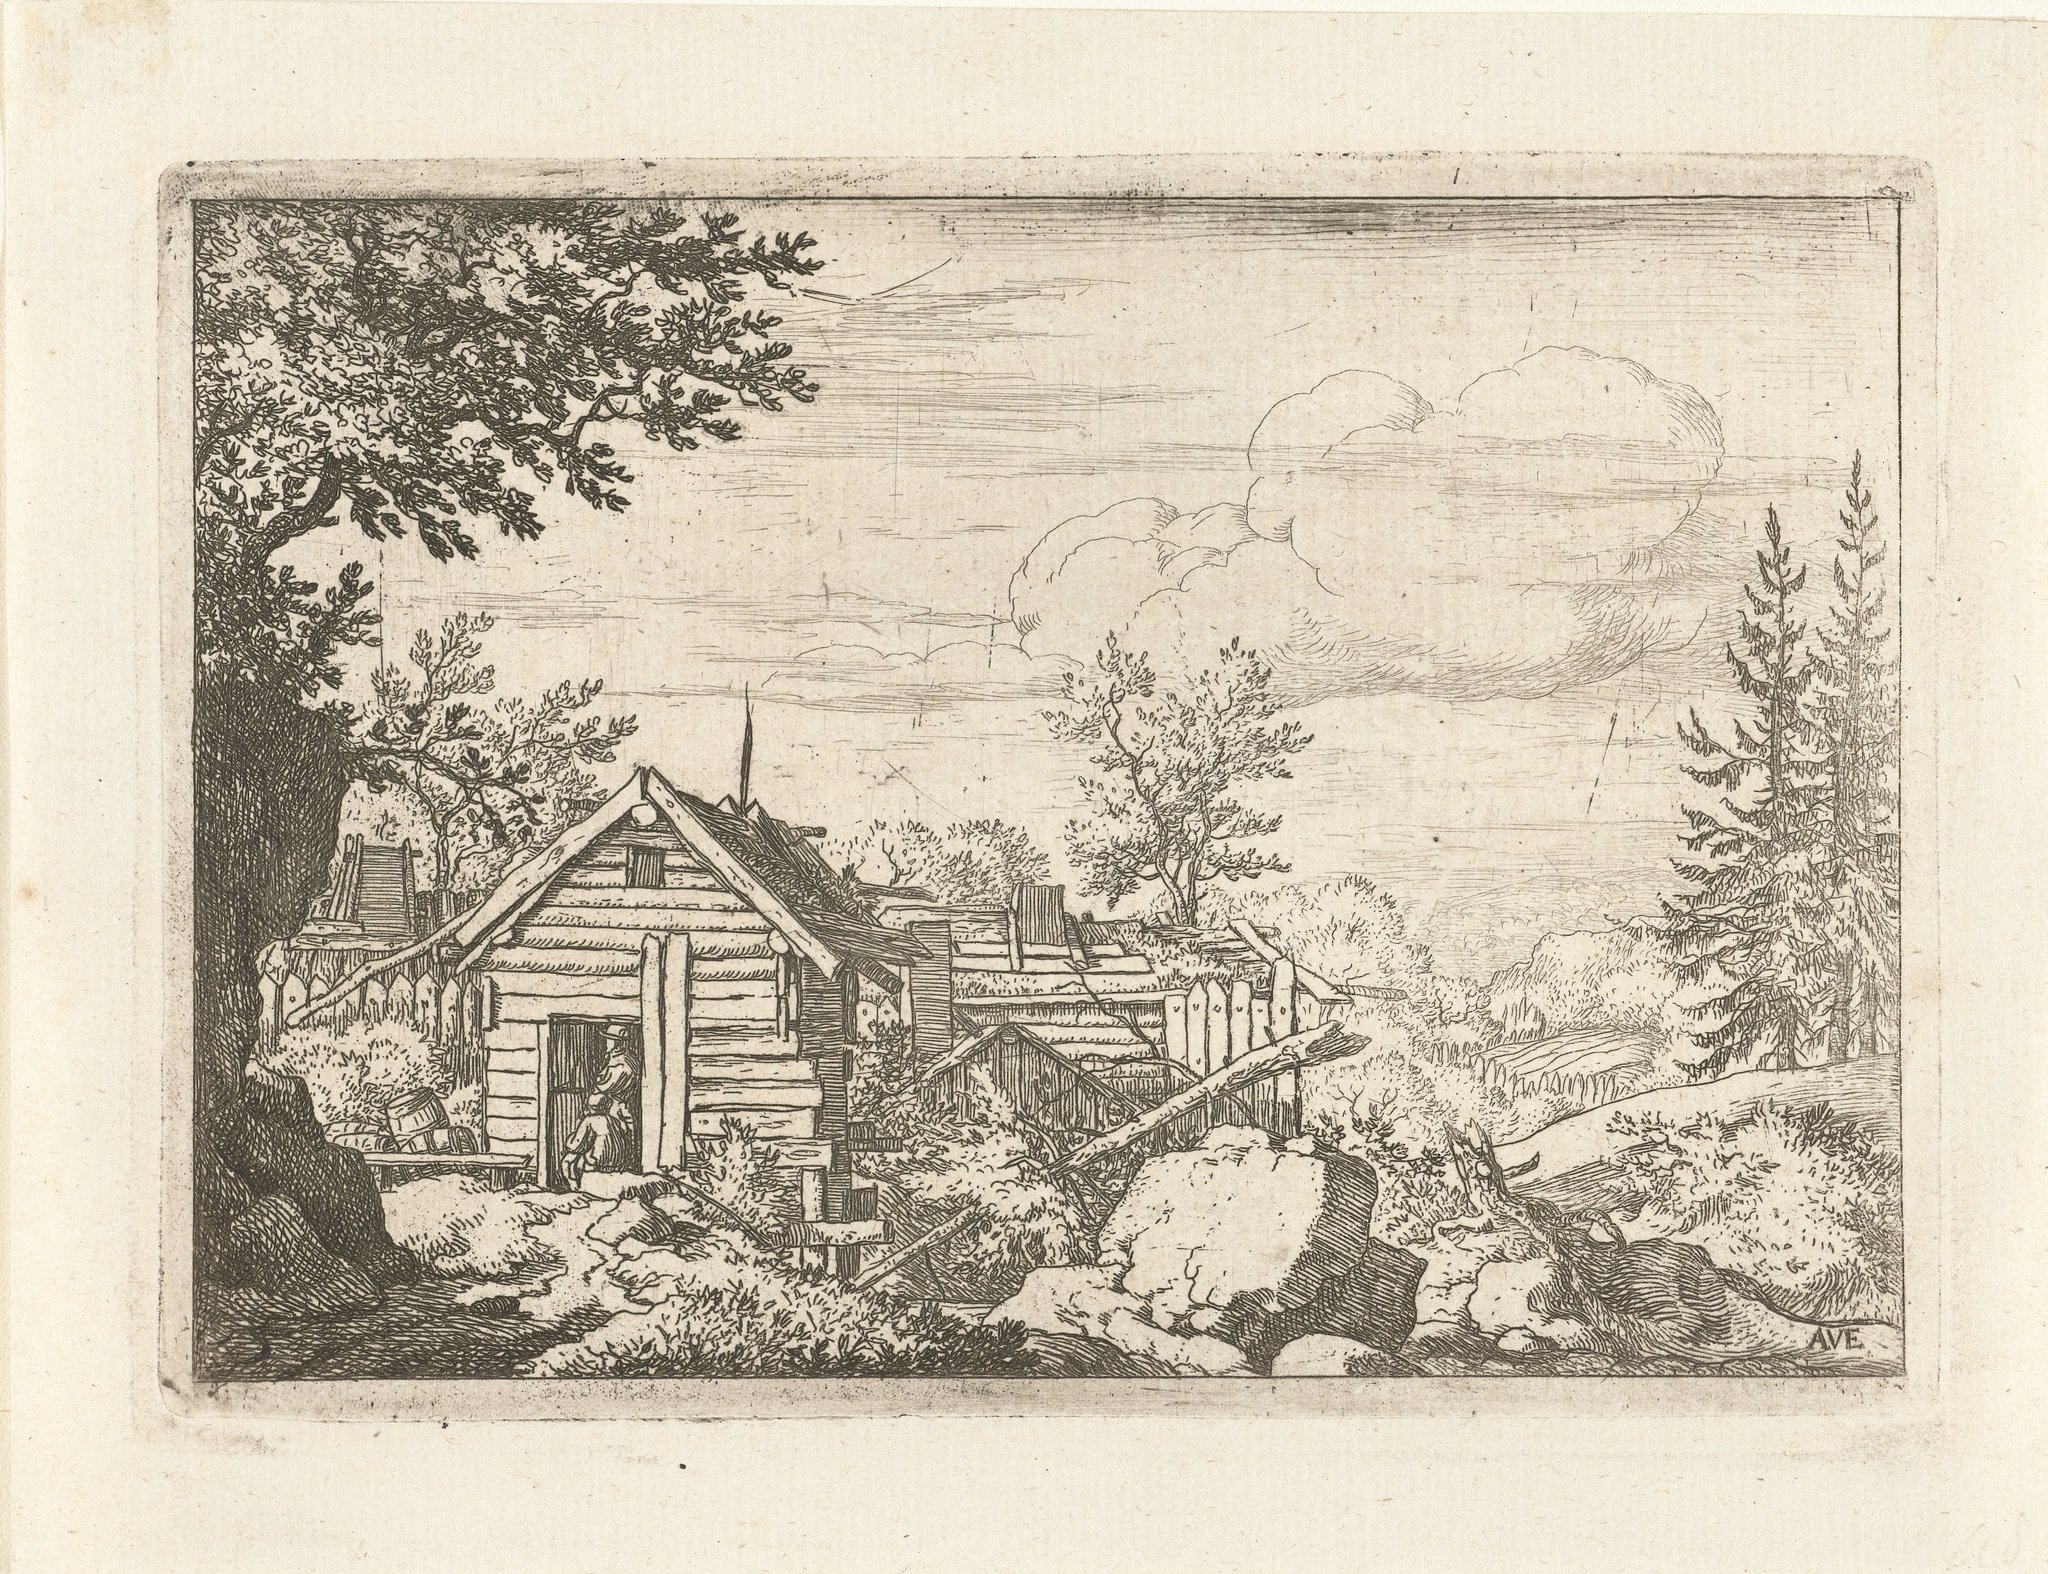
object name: print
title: Landschap met twee mannen in de deuropening van een houten hut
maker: allaert van everdingen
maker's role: draughtsman, painter, print maker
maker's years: 1621-1675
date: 1631-1675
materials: paper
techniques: etching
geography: netherlands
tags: farm or solitary house in landscape